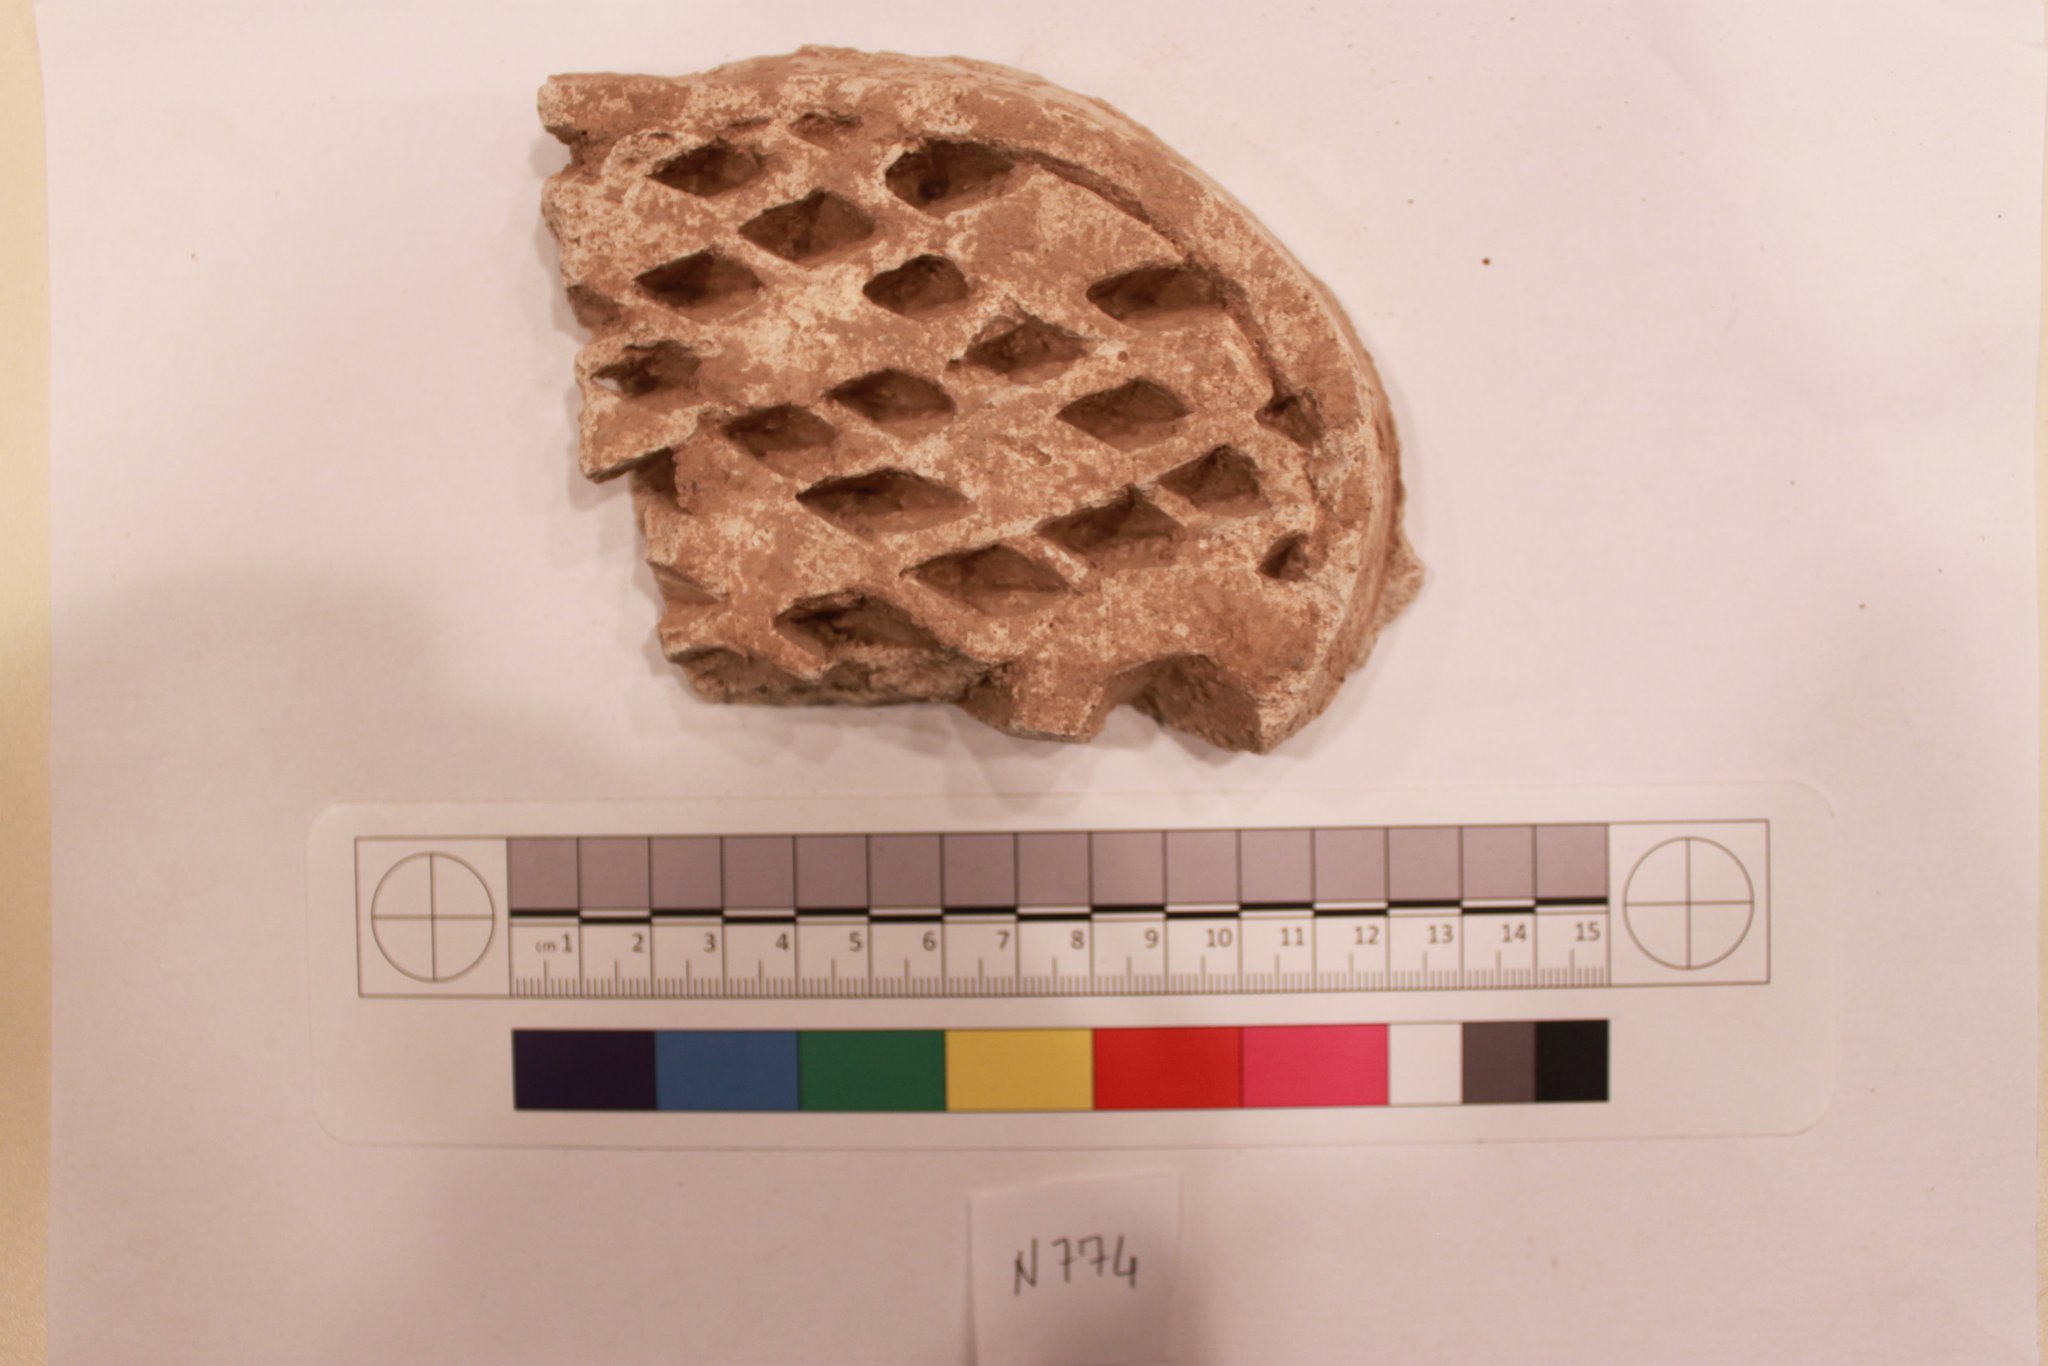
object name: fragment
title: Stucco Fragment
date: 701-1200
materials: plaster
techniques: carving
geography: iran